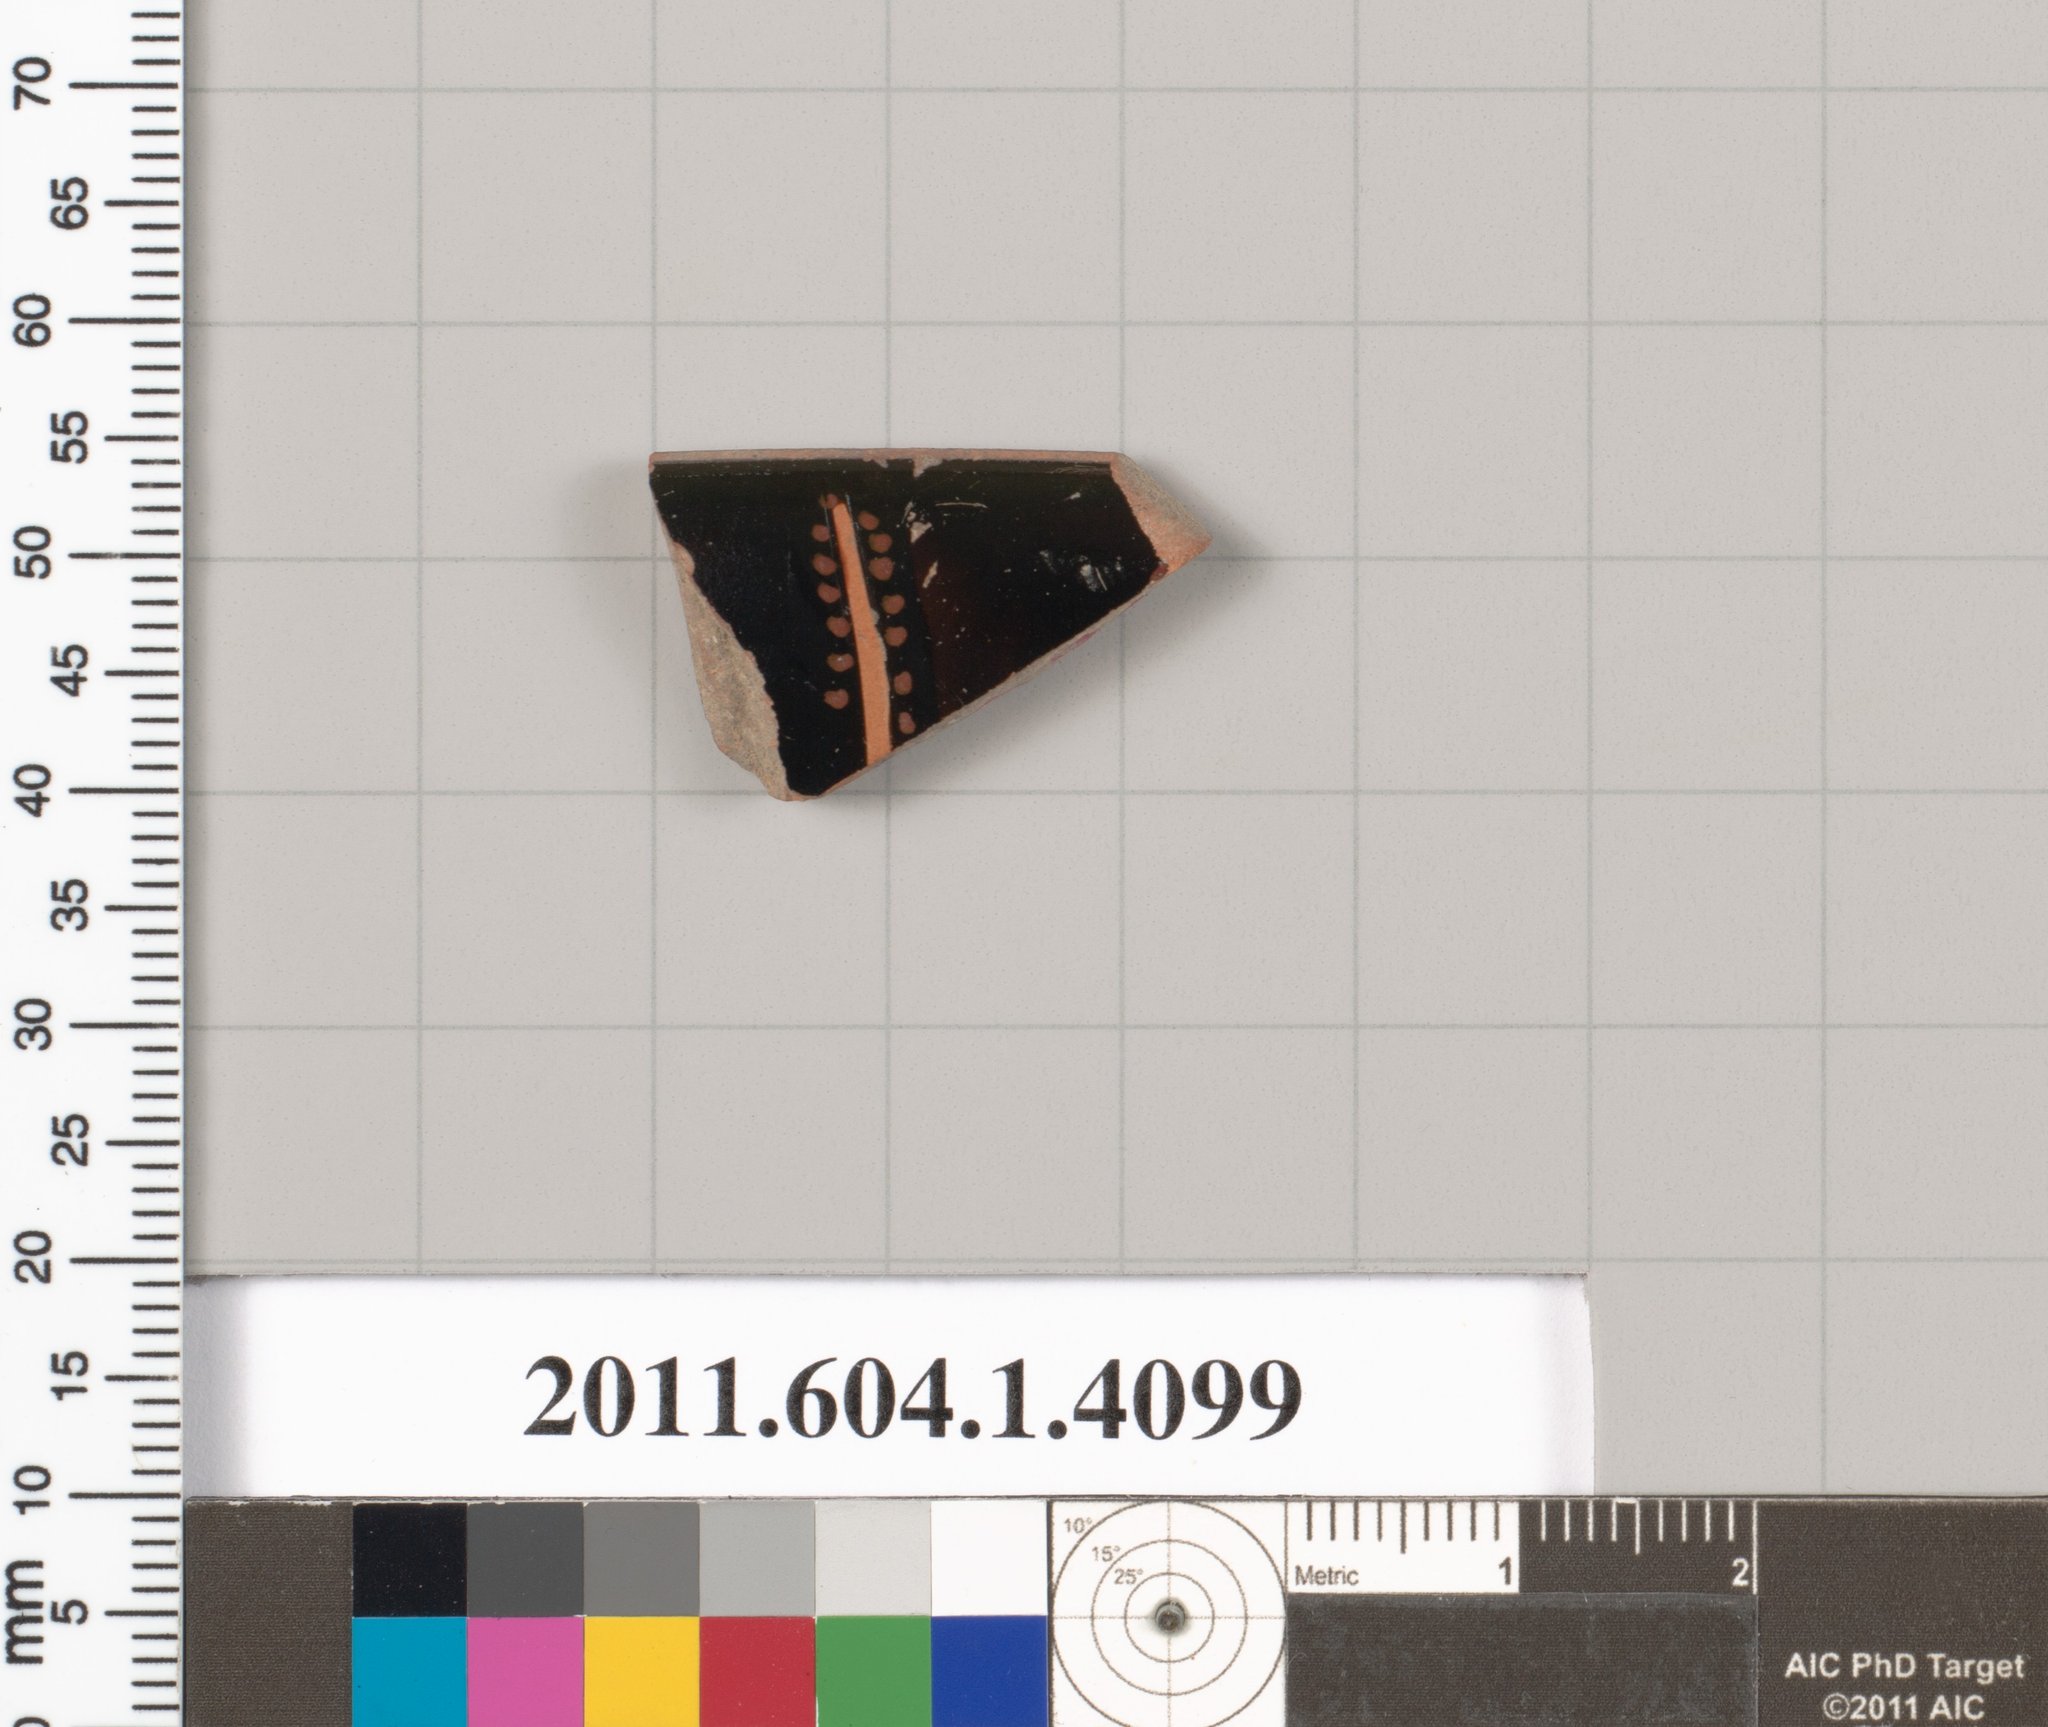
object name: kylix fragment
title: Terracotta rim fragment of a kylix (drinking cup)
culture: greek, attic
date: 500-480 BCE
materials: terracotta